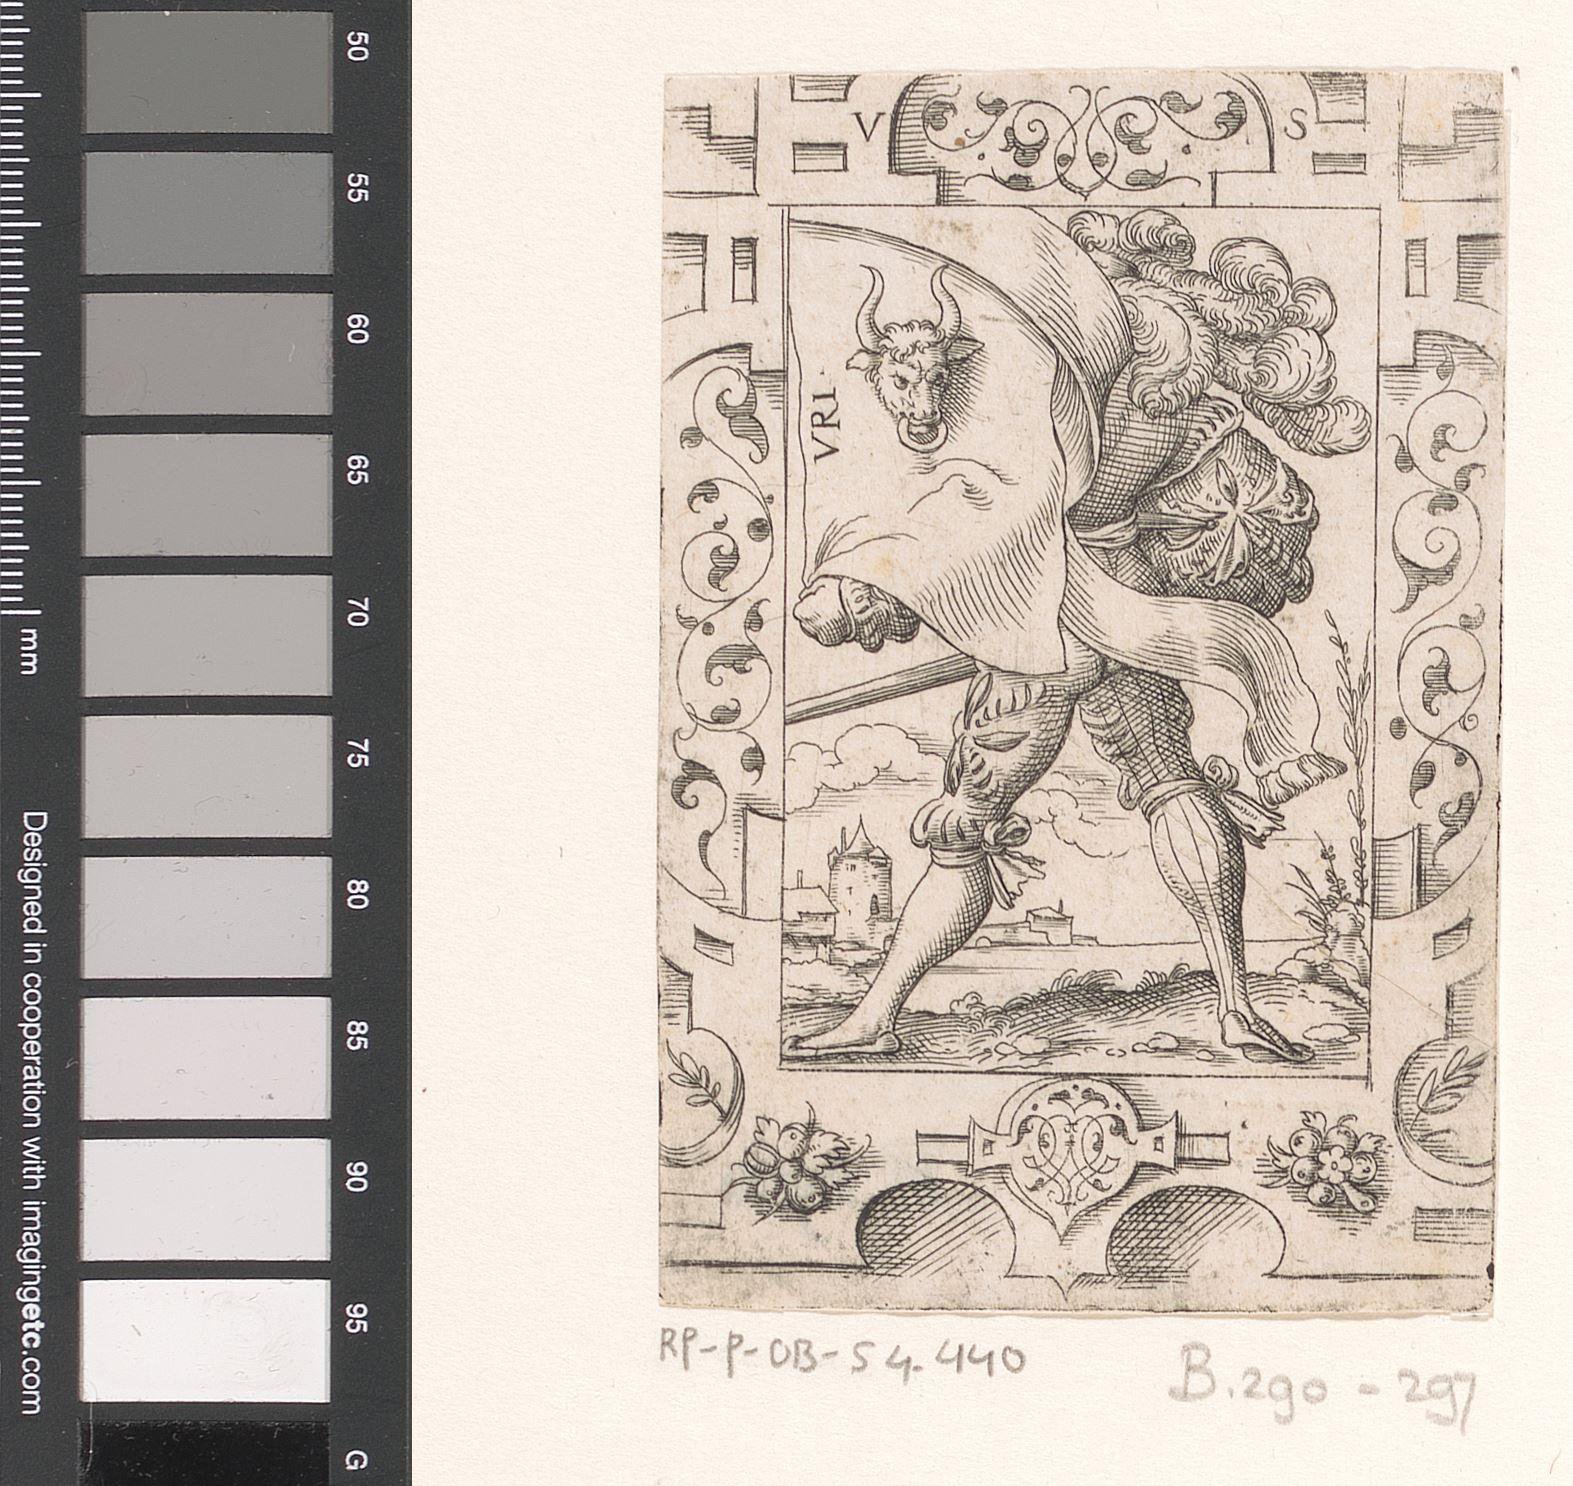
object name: print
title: Uri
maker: virgilius solis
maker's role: draughtsman, print maker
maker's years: 1514-1562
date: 1524-1562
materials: paper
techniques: engraving, etching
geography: nuremberg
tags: scrollwork, strapwork ~ ornament, (military) standard-bearer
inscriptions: number: ‘145’, collector's mark: Lugt 2228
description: Prent maakt deel uit van een serie van veertien prenten met voorstellingen van vaandeldragers met vaandels van de Zwitserse kantons.